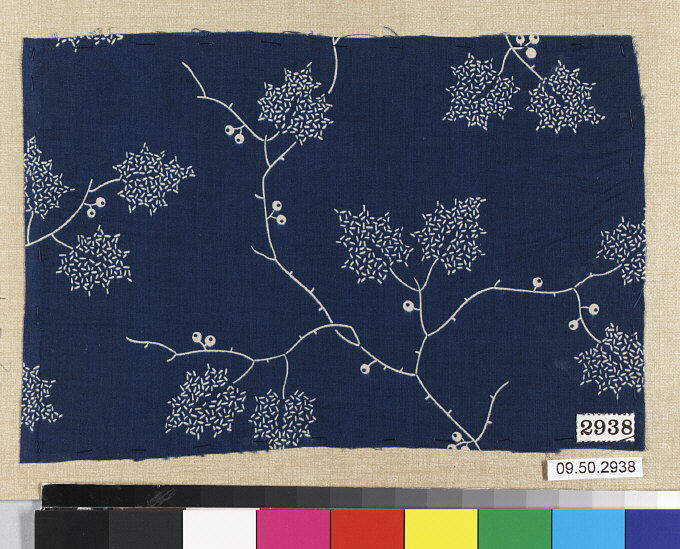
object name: piece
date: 1801-1900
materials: cotton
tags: leaves